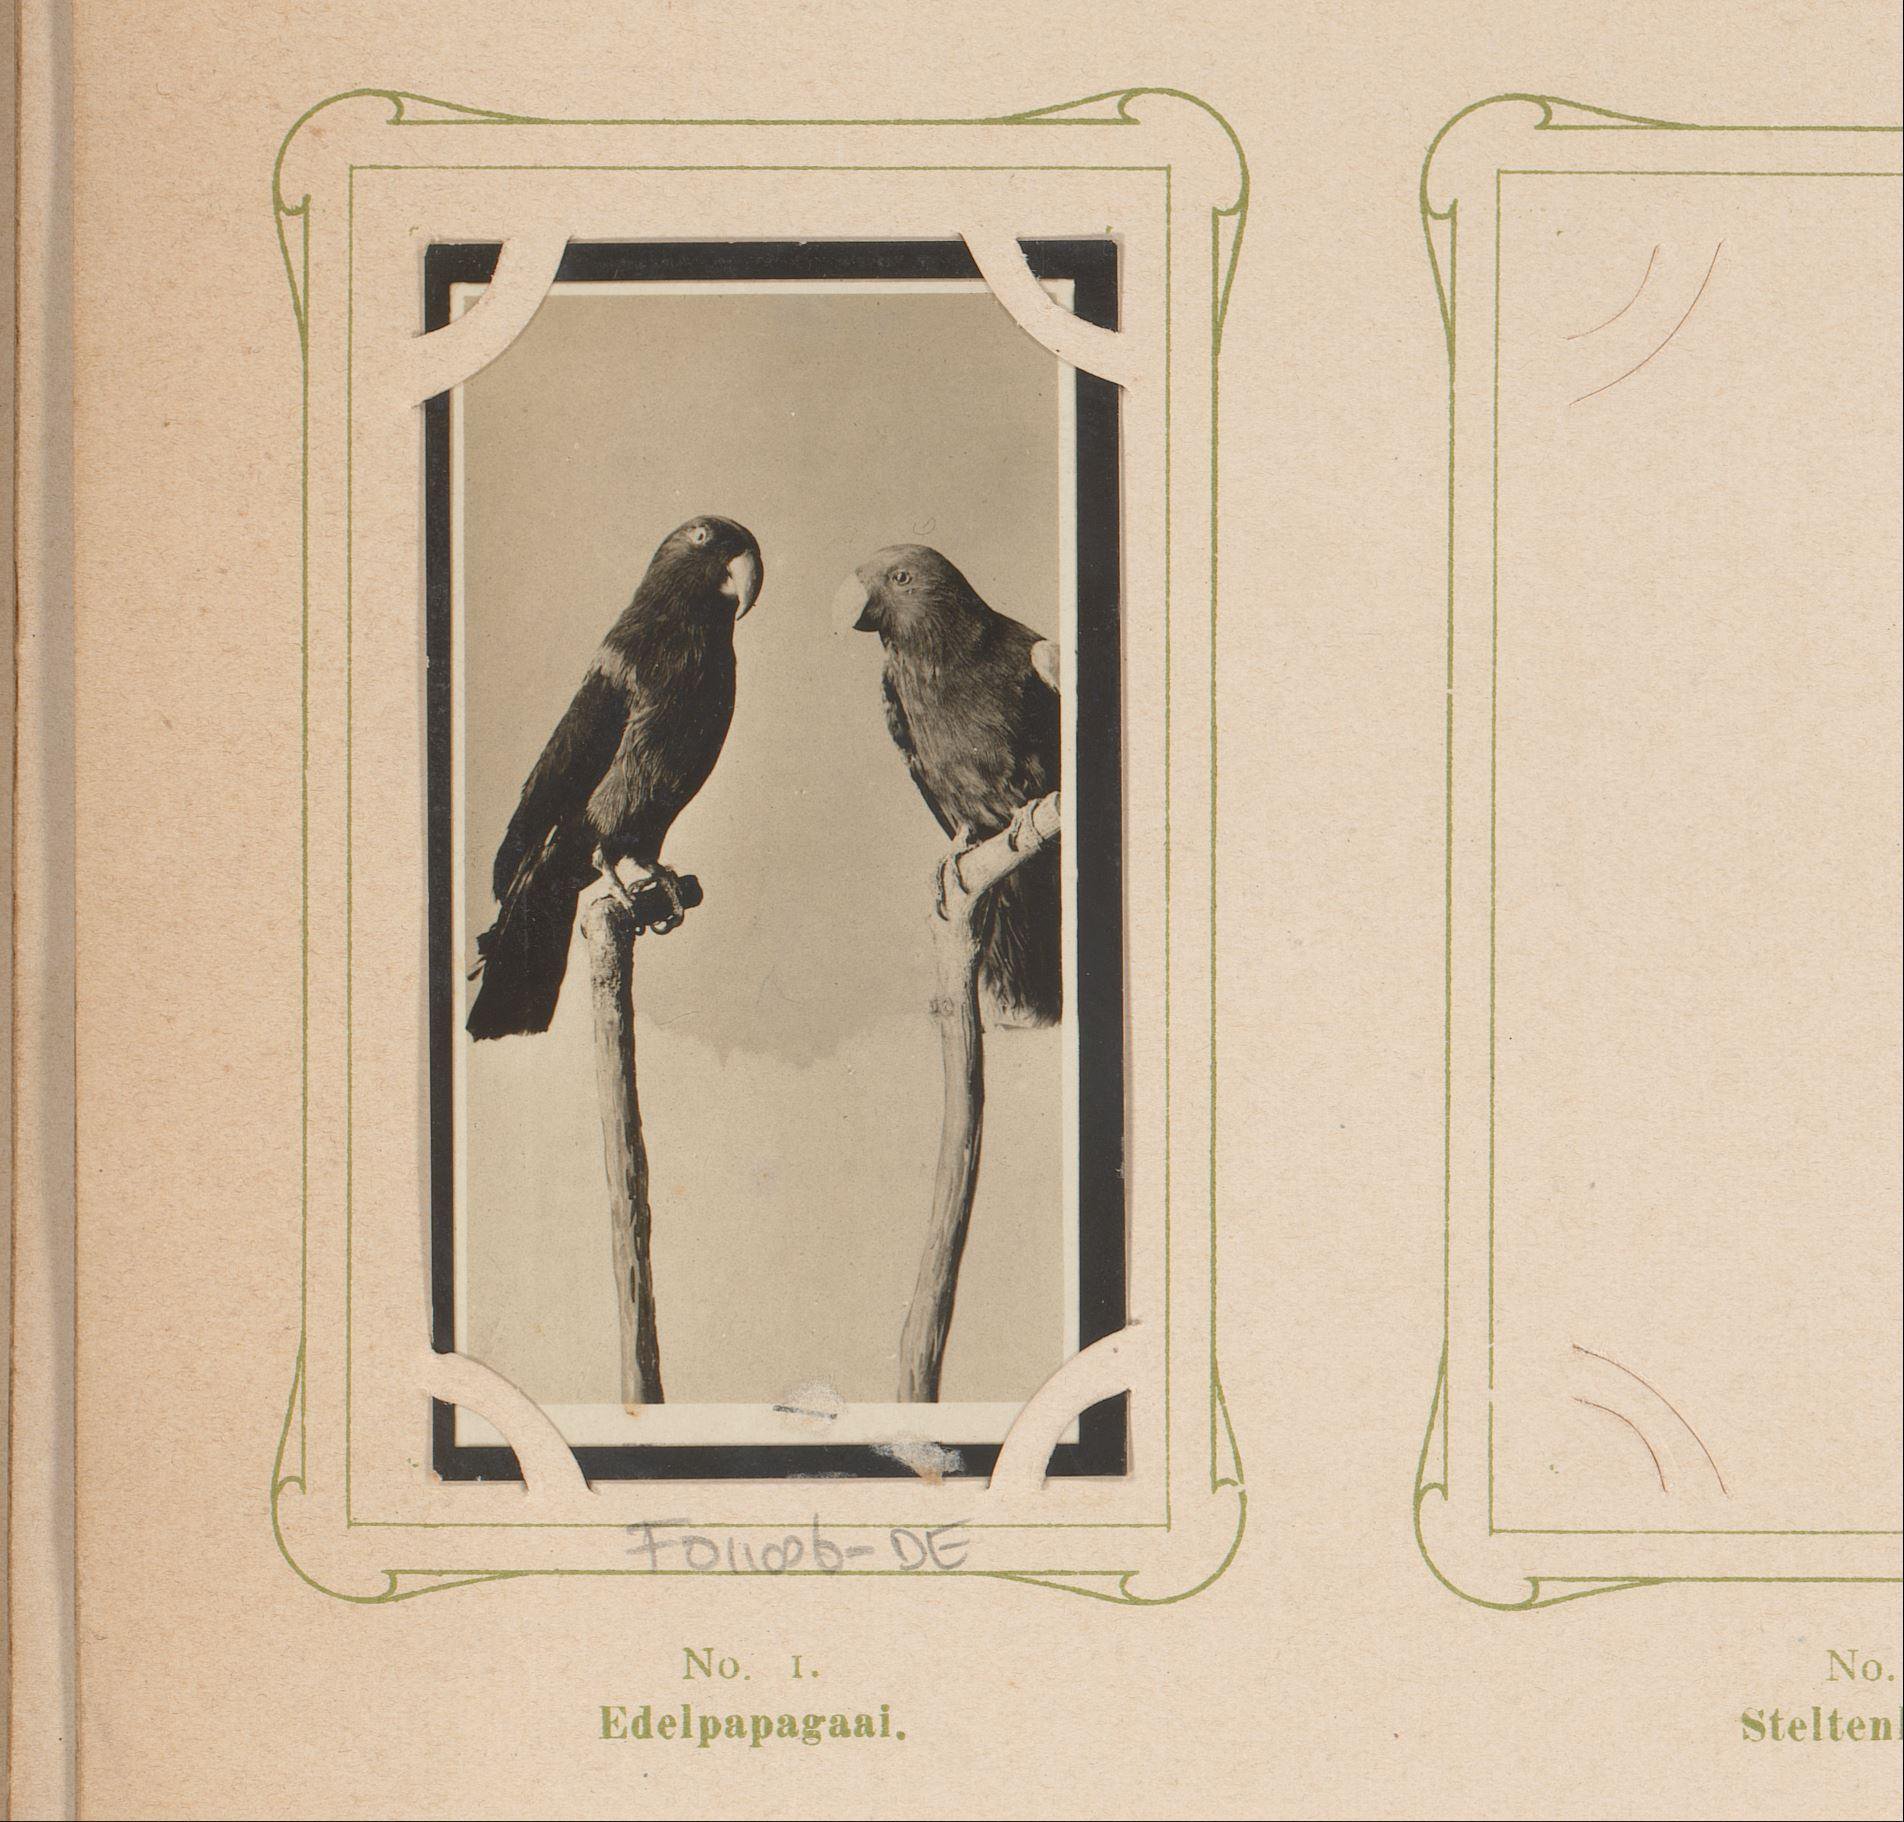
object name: album leaf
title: Twee edelpapegaaien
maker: Anonymous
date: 1904-1905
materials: photographic support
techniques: gelatin silver print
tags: ornamental birds: parrot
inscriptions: inscription: ‘No. 1./ Edelpapagaai.’